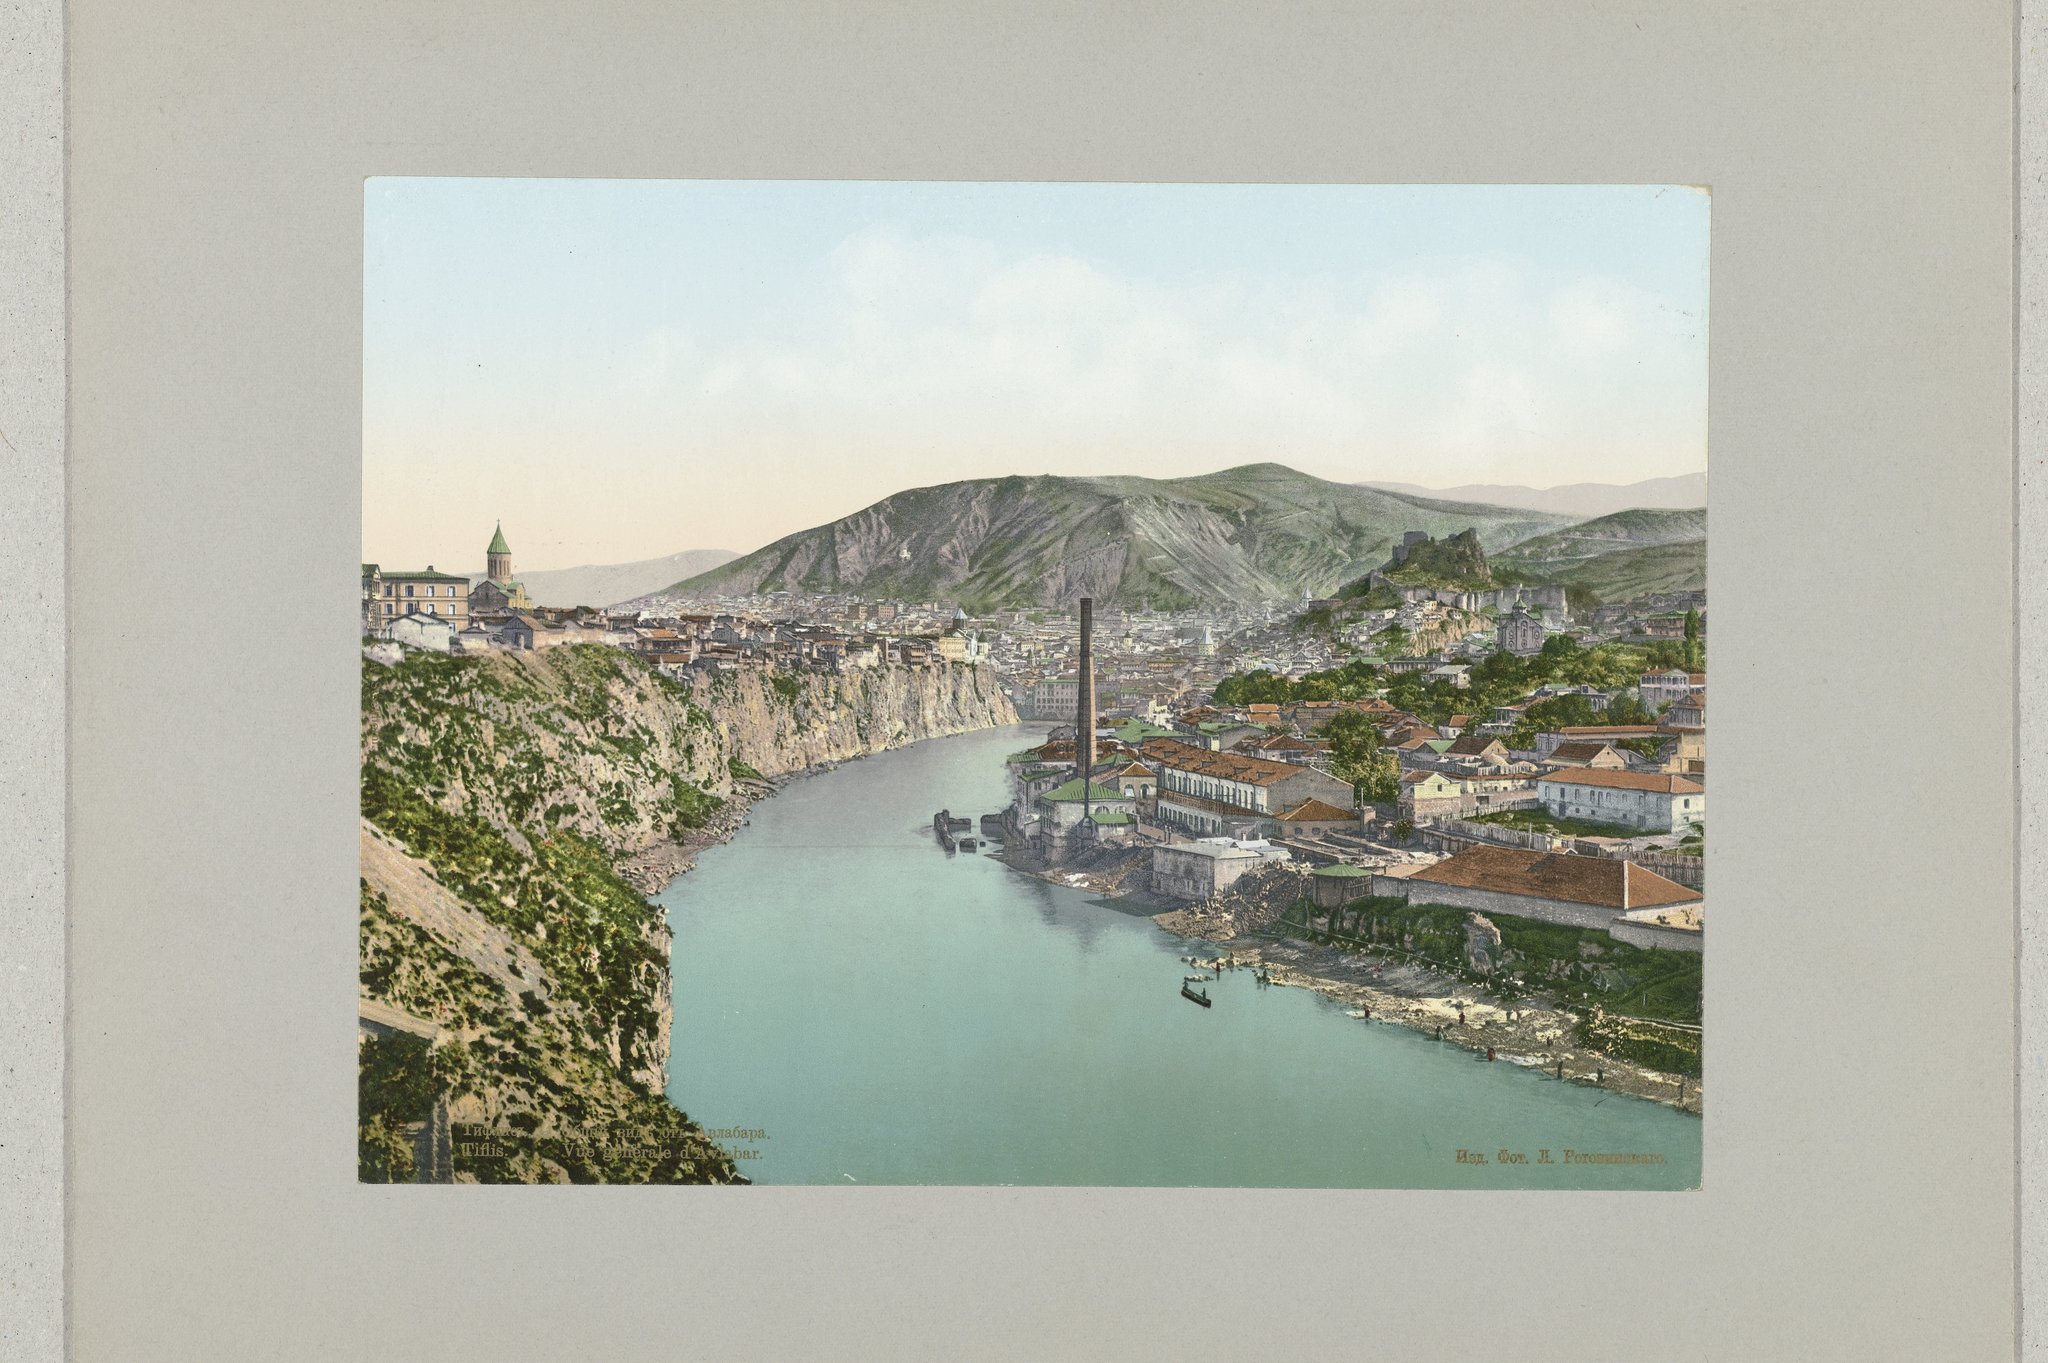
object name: photograph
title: Tiflis. Vue generale d'Avlabar.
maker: Anonymous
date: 1895-1915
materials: cardboard, paper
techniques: photolithography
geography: tbilisi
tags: tbilisi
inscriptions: annotation: ‘35. Tiflis.’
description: Uitzicht op de buurt Avlabar. Linksonder staat de titel in het Russisch en in het Frans.